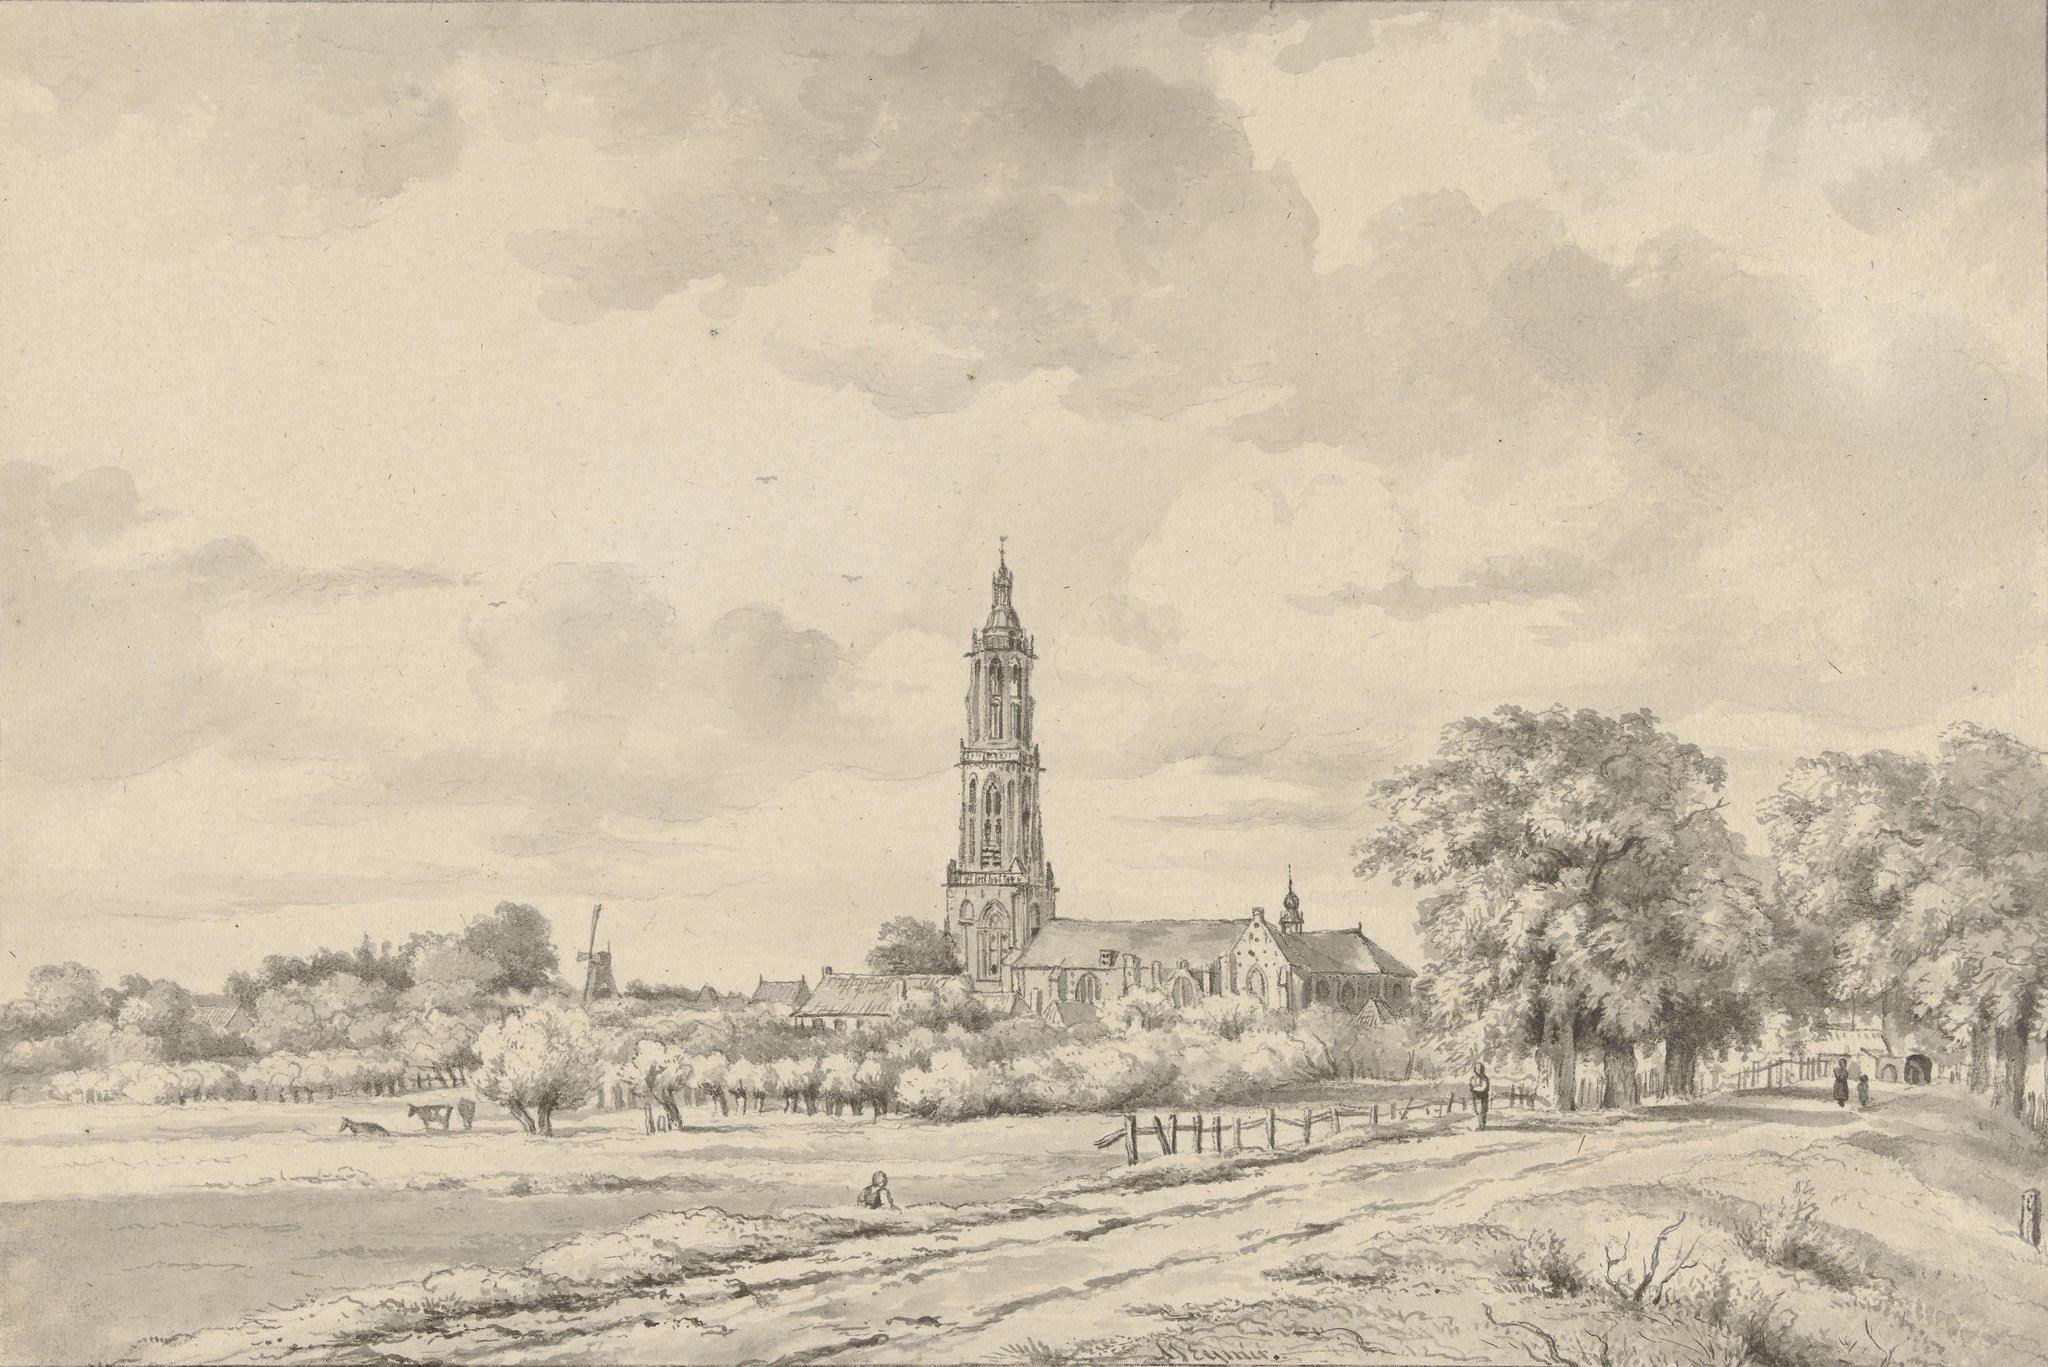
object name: drawing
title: Gezicht op Rhenen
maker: arnoldus johannes eymer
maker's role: draughtsman, print maker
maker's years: 1803-1863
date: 1813-1863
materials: chalk, paper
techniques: brush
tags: prospect of city, town panorama, silhouette of city, rhenen